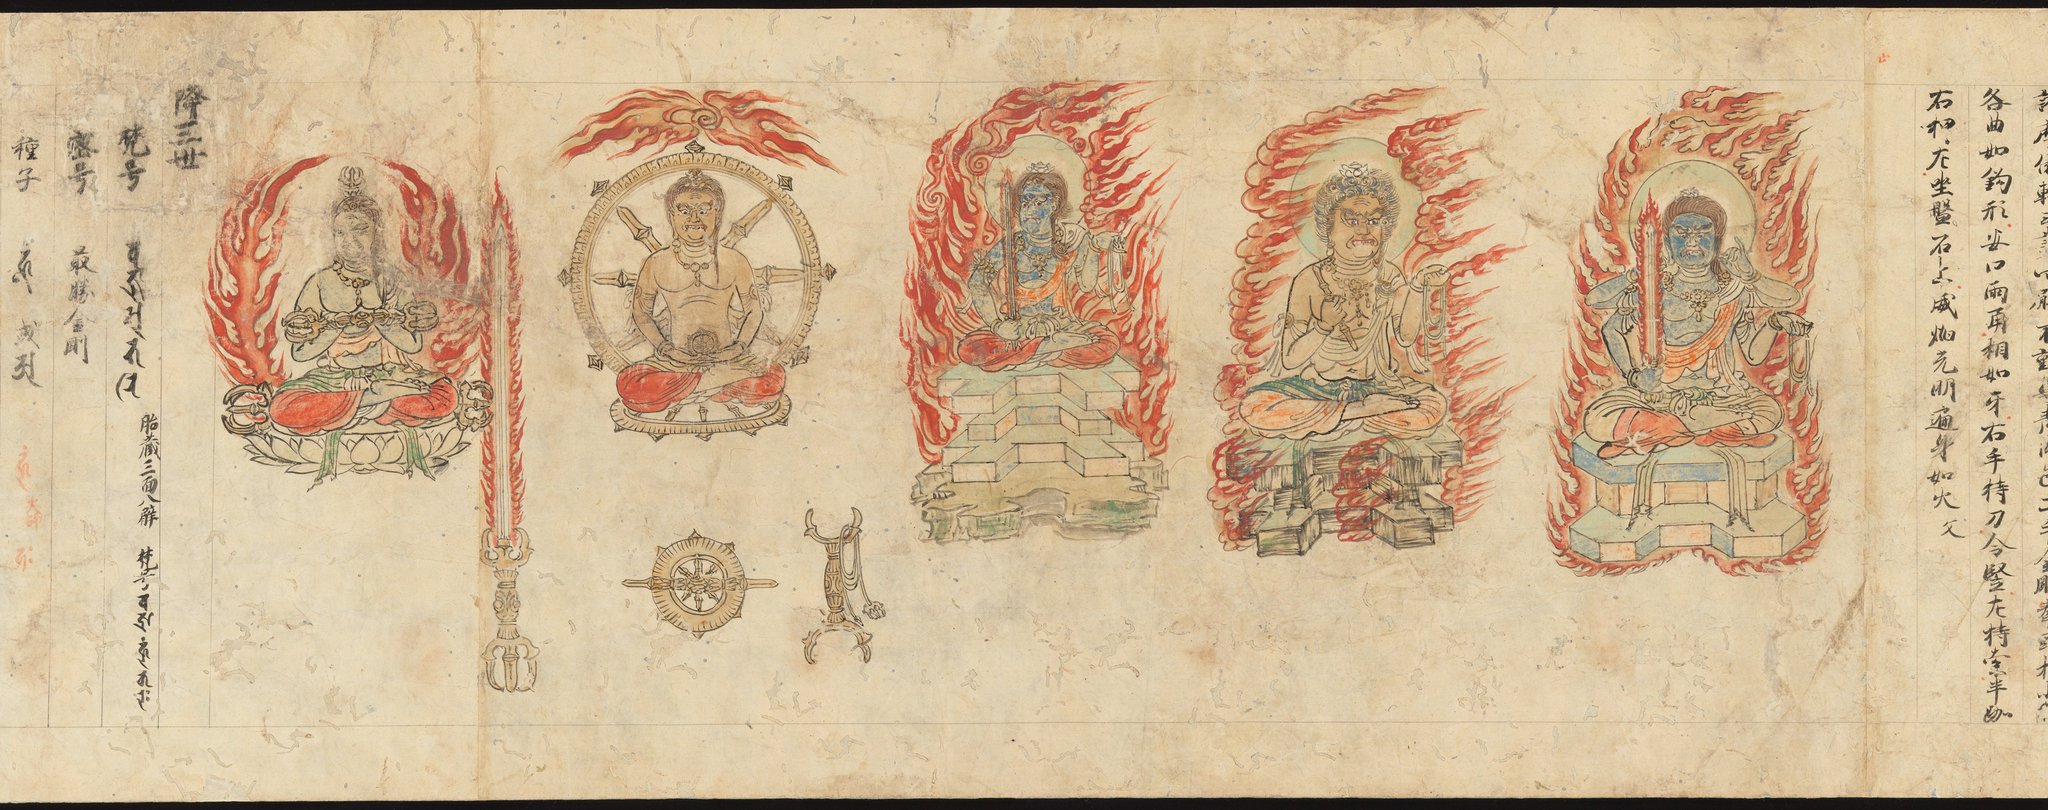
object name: handscroll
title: Iconographic Drawings of the Five Kings of Wisdom (Myōō-bu shoson)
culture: japanese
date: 1101-1200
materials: ink, paper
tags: swords,buddhism,deities